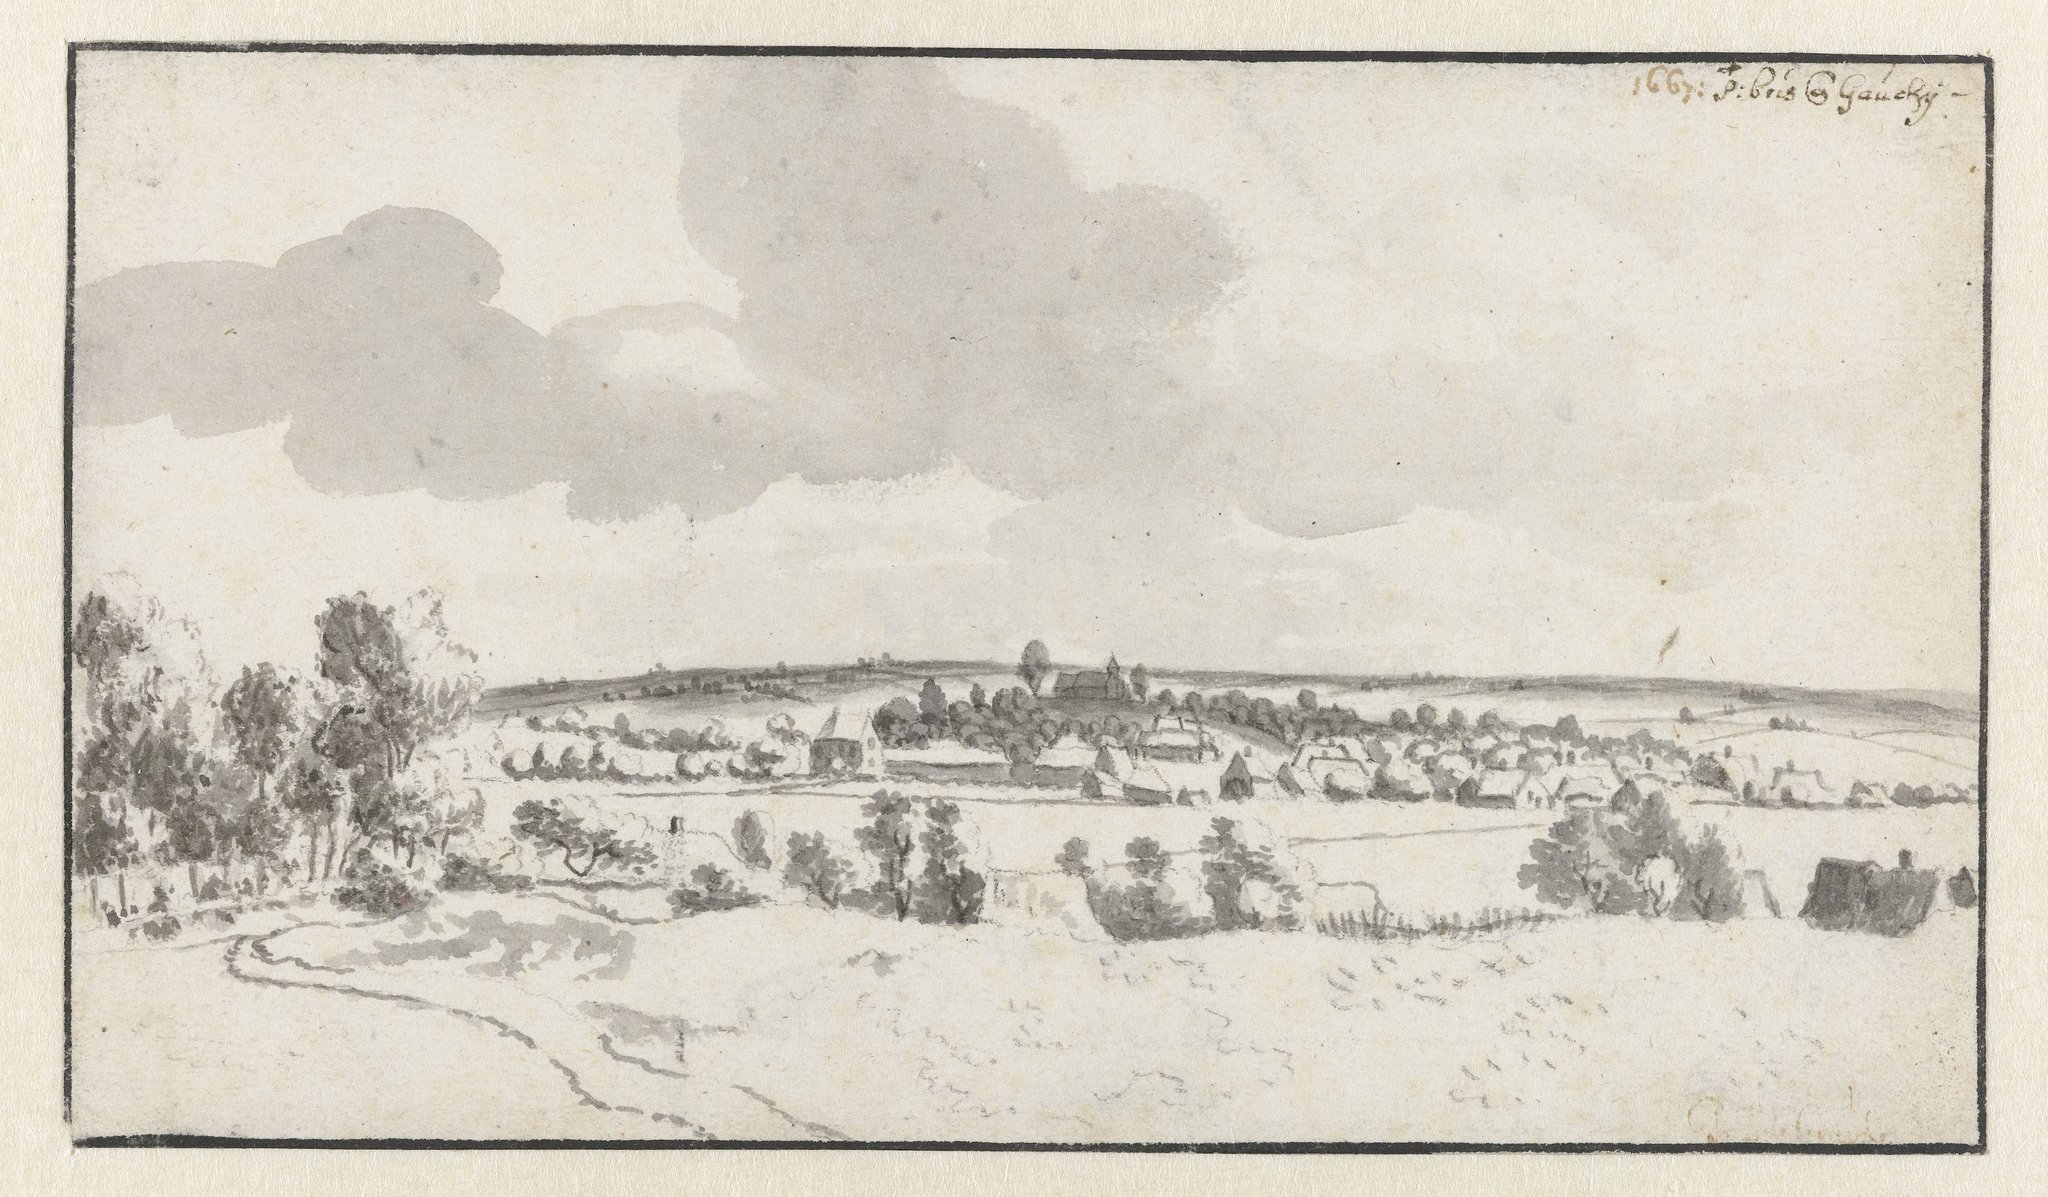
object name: drawing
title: Hilly Landscape near Gauchy, Aisne, Hauts-de-France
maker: josua de grave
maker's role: draughtsman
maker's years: 1645-1712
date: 1667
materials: chalk, paper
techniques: brush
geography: gauchy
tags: prospect of village, silhouette of village, gauchy